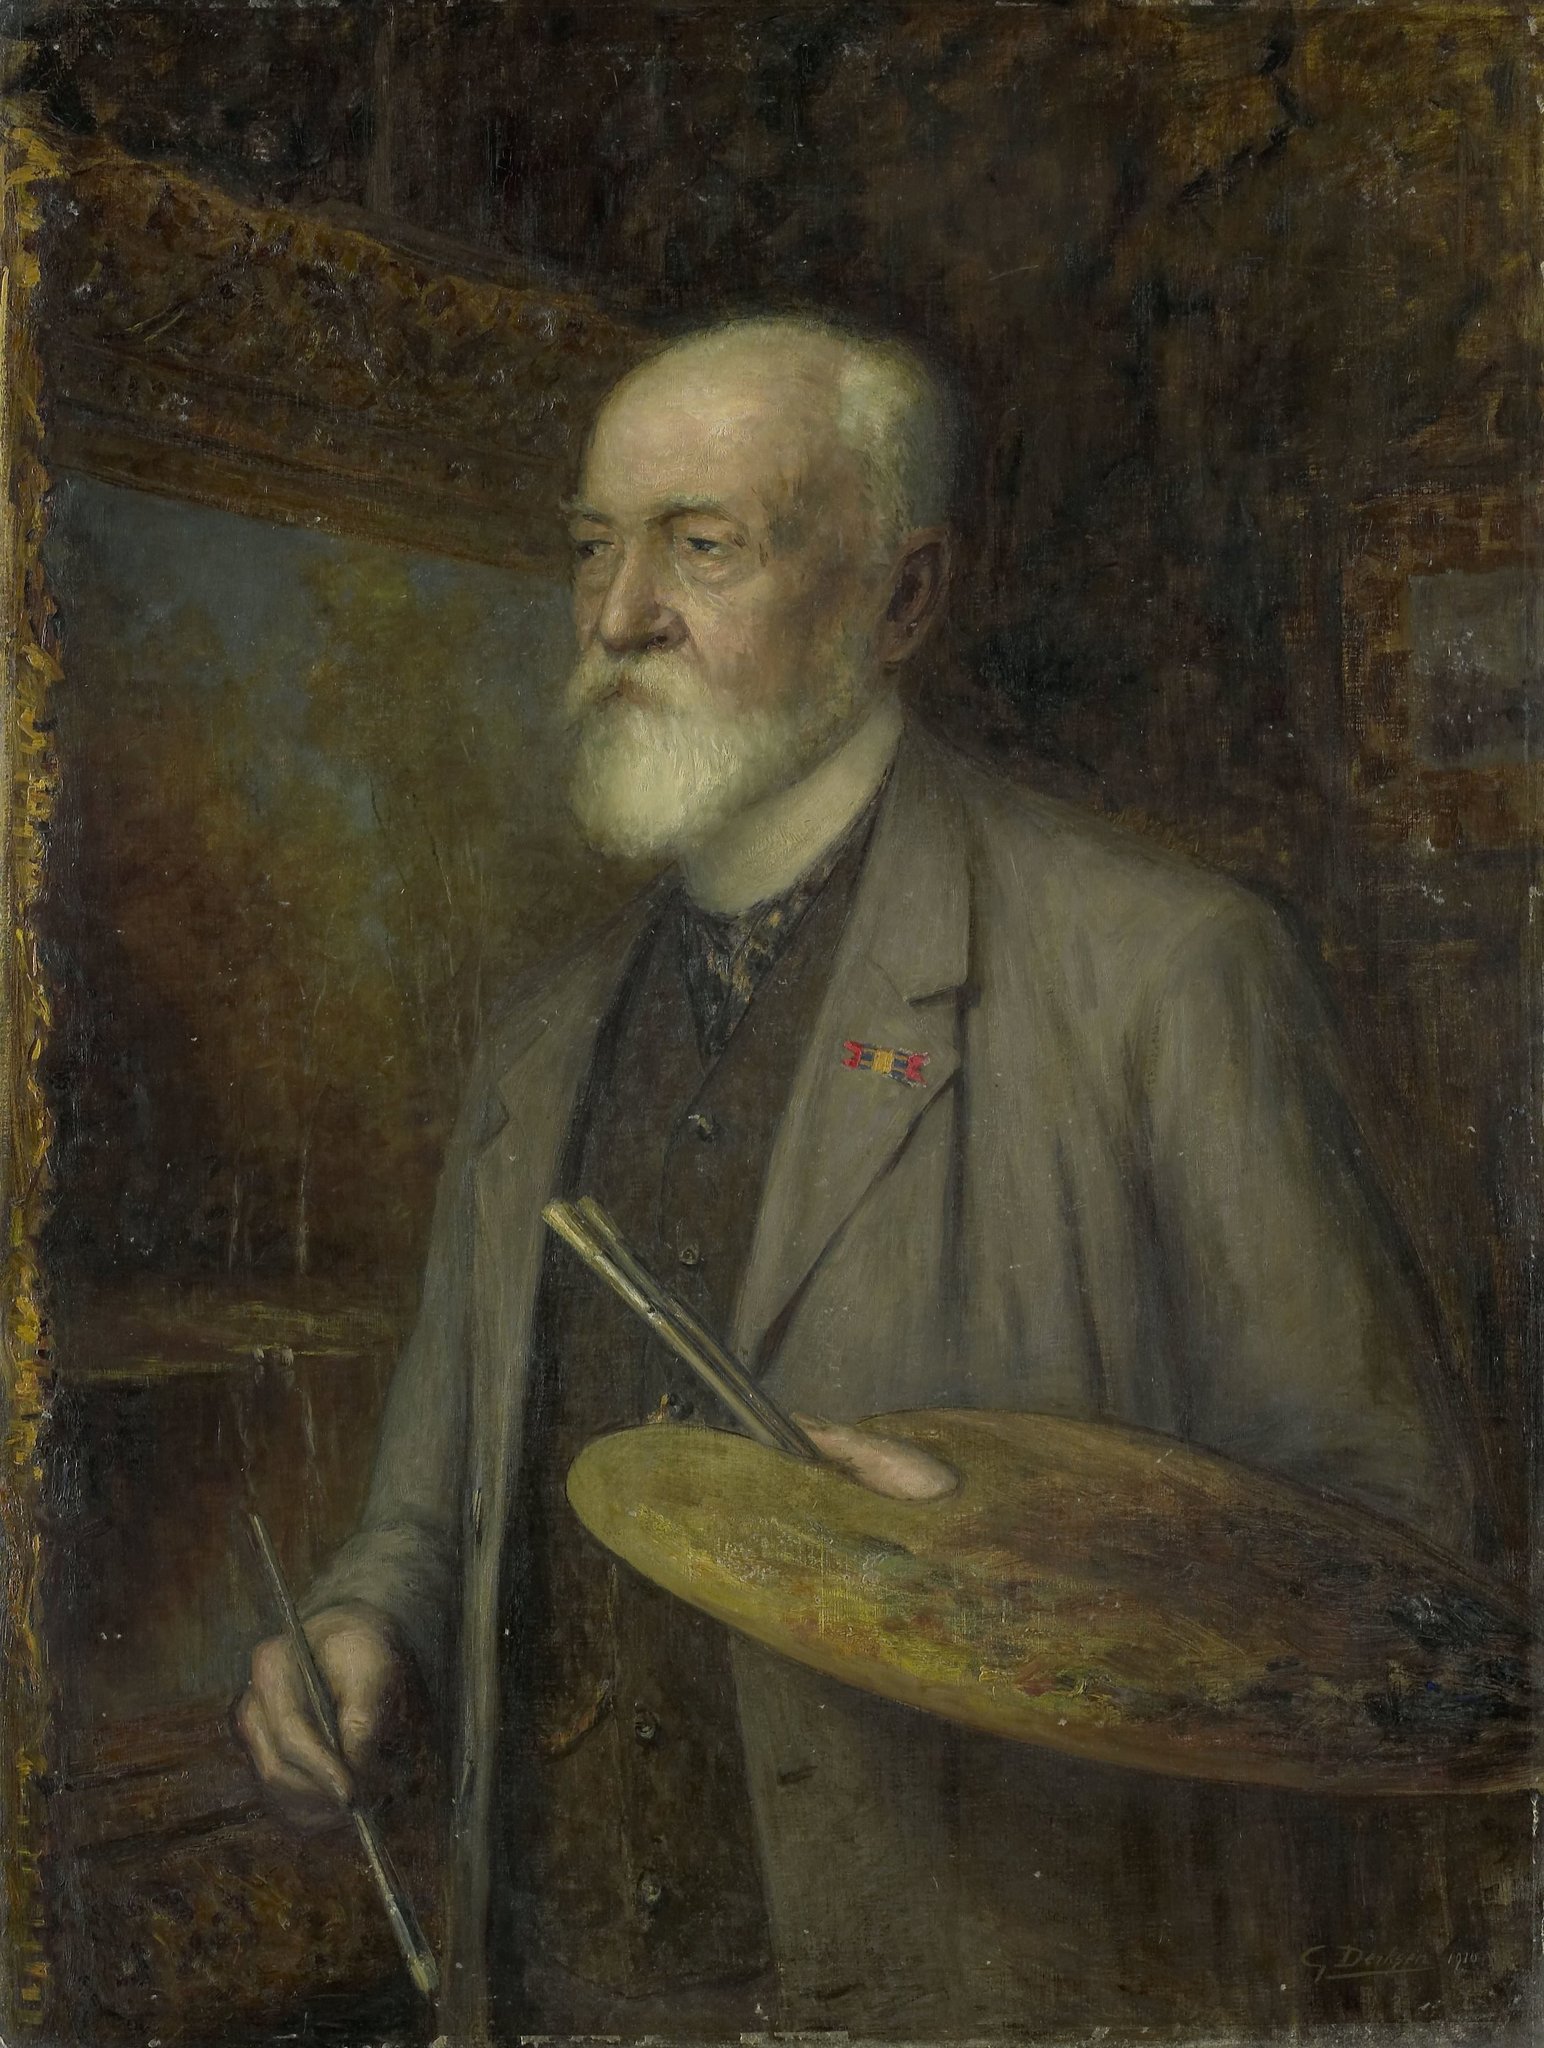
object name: painting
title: Johannes Gijsbert Vogel (1828-1915), Painter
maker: gijsbertus derksen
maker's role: draughtsman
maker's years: 1870-1920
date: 1910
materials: canvas, oil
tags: painter, print maker, johannes gijsbert vogel, historical persons, portrait, self-portrait of painter, portrait, self-portrait of artist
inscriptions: signature and date: ‘G Derksen. 1910’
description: Portret van de schilder Johannes Gijsbert Vogel. Staande voor een schilderij op de ezel, penseel in de rechterhand, palet met penselen in de linkerhand.